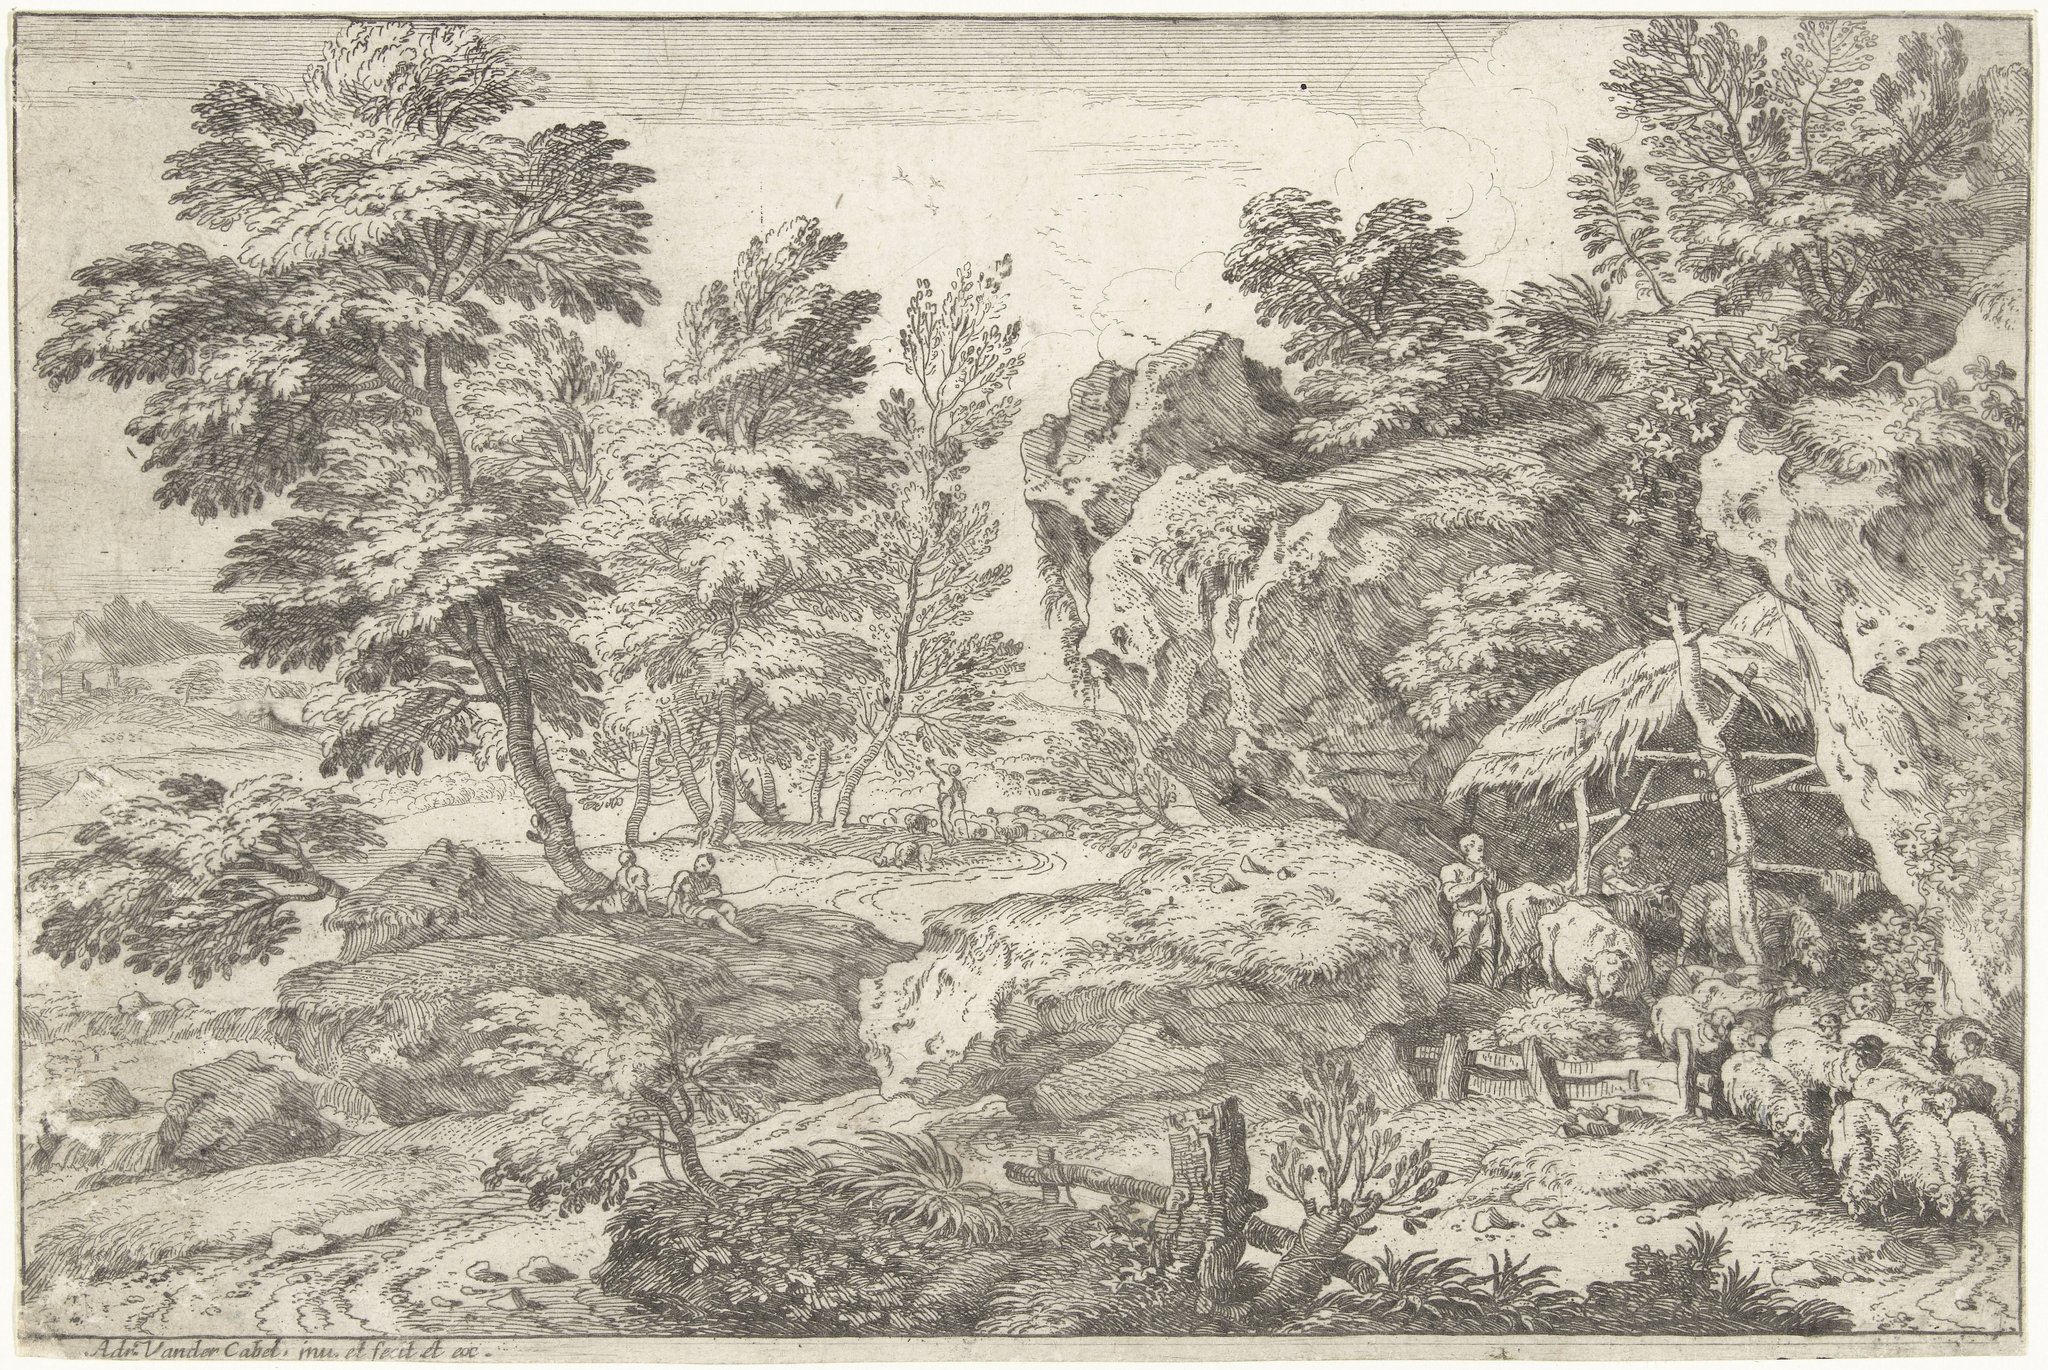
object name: print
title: Landschap met schaapskooi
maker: adriaen van der kabel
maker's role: draughtsman, painter, print maker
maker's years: 1630-1705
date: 1648-1705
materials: paper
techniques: etching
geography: france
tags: landscapes, herding, herdsman, herdswoman, shepherd, shepherdess, cowherd, etc.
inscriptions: collector's mark: Lugt 2228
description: Landschap met op de voorgrond, rechts, een schaapskooi met de herder staand bij enkele koeien, terwijl de schapen de kooi verlaten. Eerste prent uit de serie van zes.